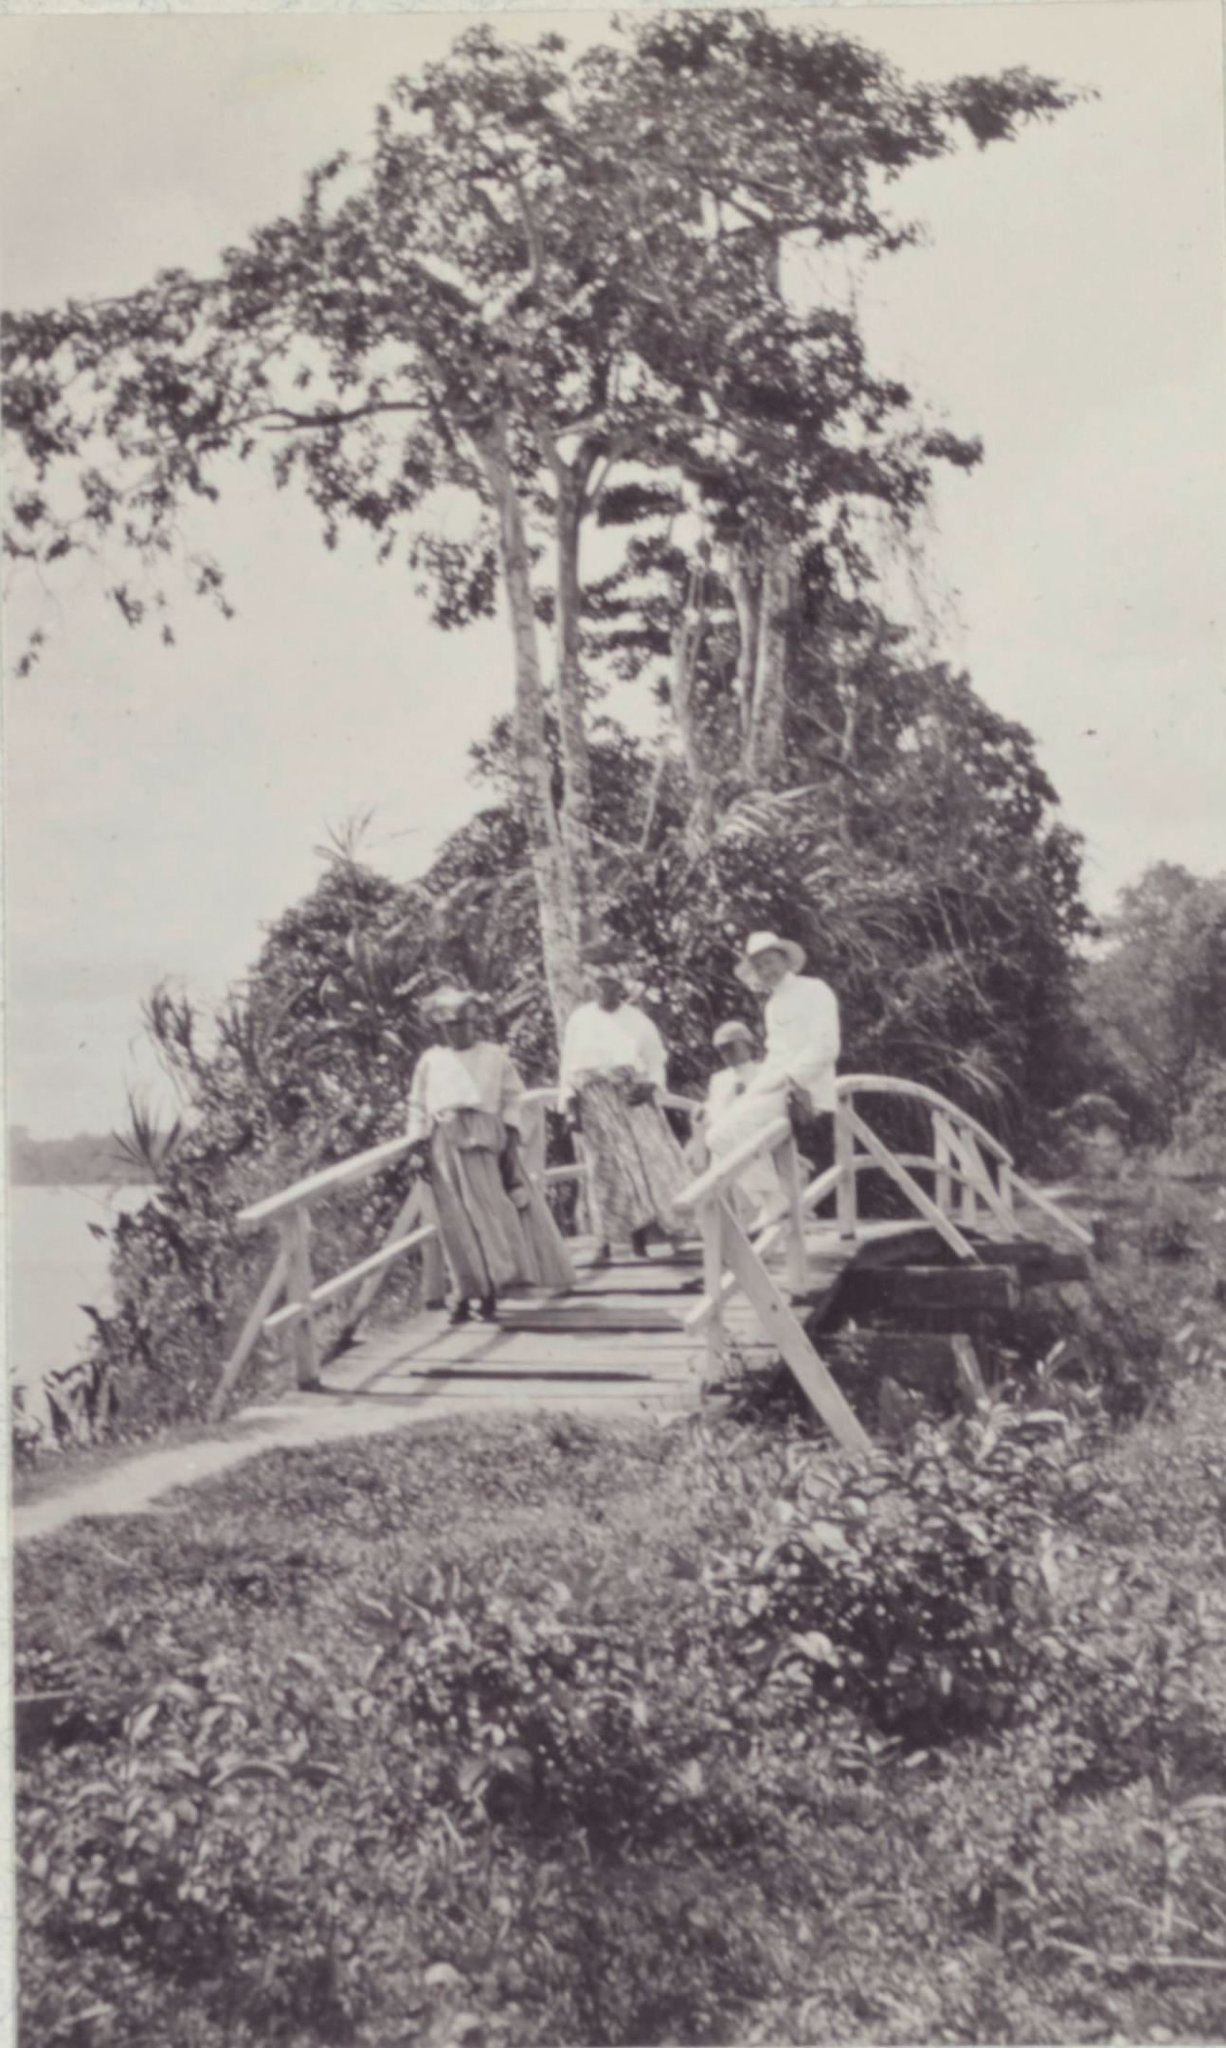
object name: photograph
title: Bij Groningen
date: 1911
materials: photographic support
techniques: photography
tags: andries augustus boom, landscapes in tropical and sub-tropical regions, suriname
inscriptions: inscription: ‘Brug te Groningen, district beneden Saramacca Nov. 1911’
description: Andries Boom en een andere man samen met twee Surinaamse vrouwen op een bruggetje bij Groningen, november 1911. Onderdeel van het fotoalbum van de familie Boom-Gonggrijp in Suriname en Curaçao.